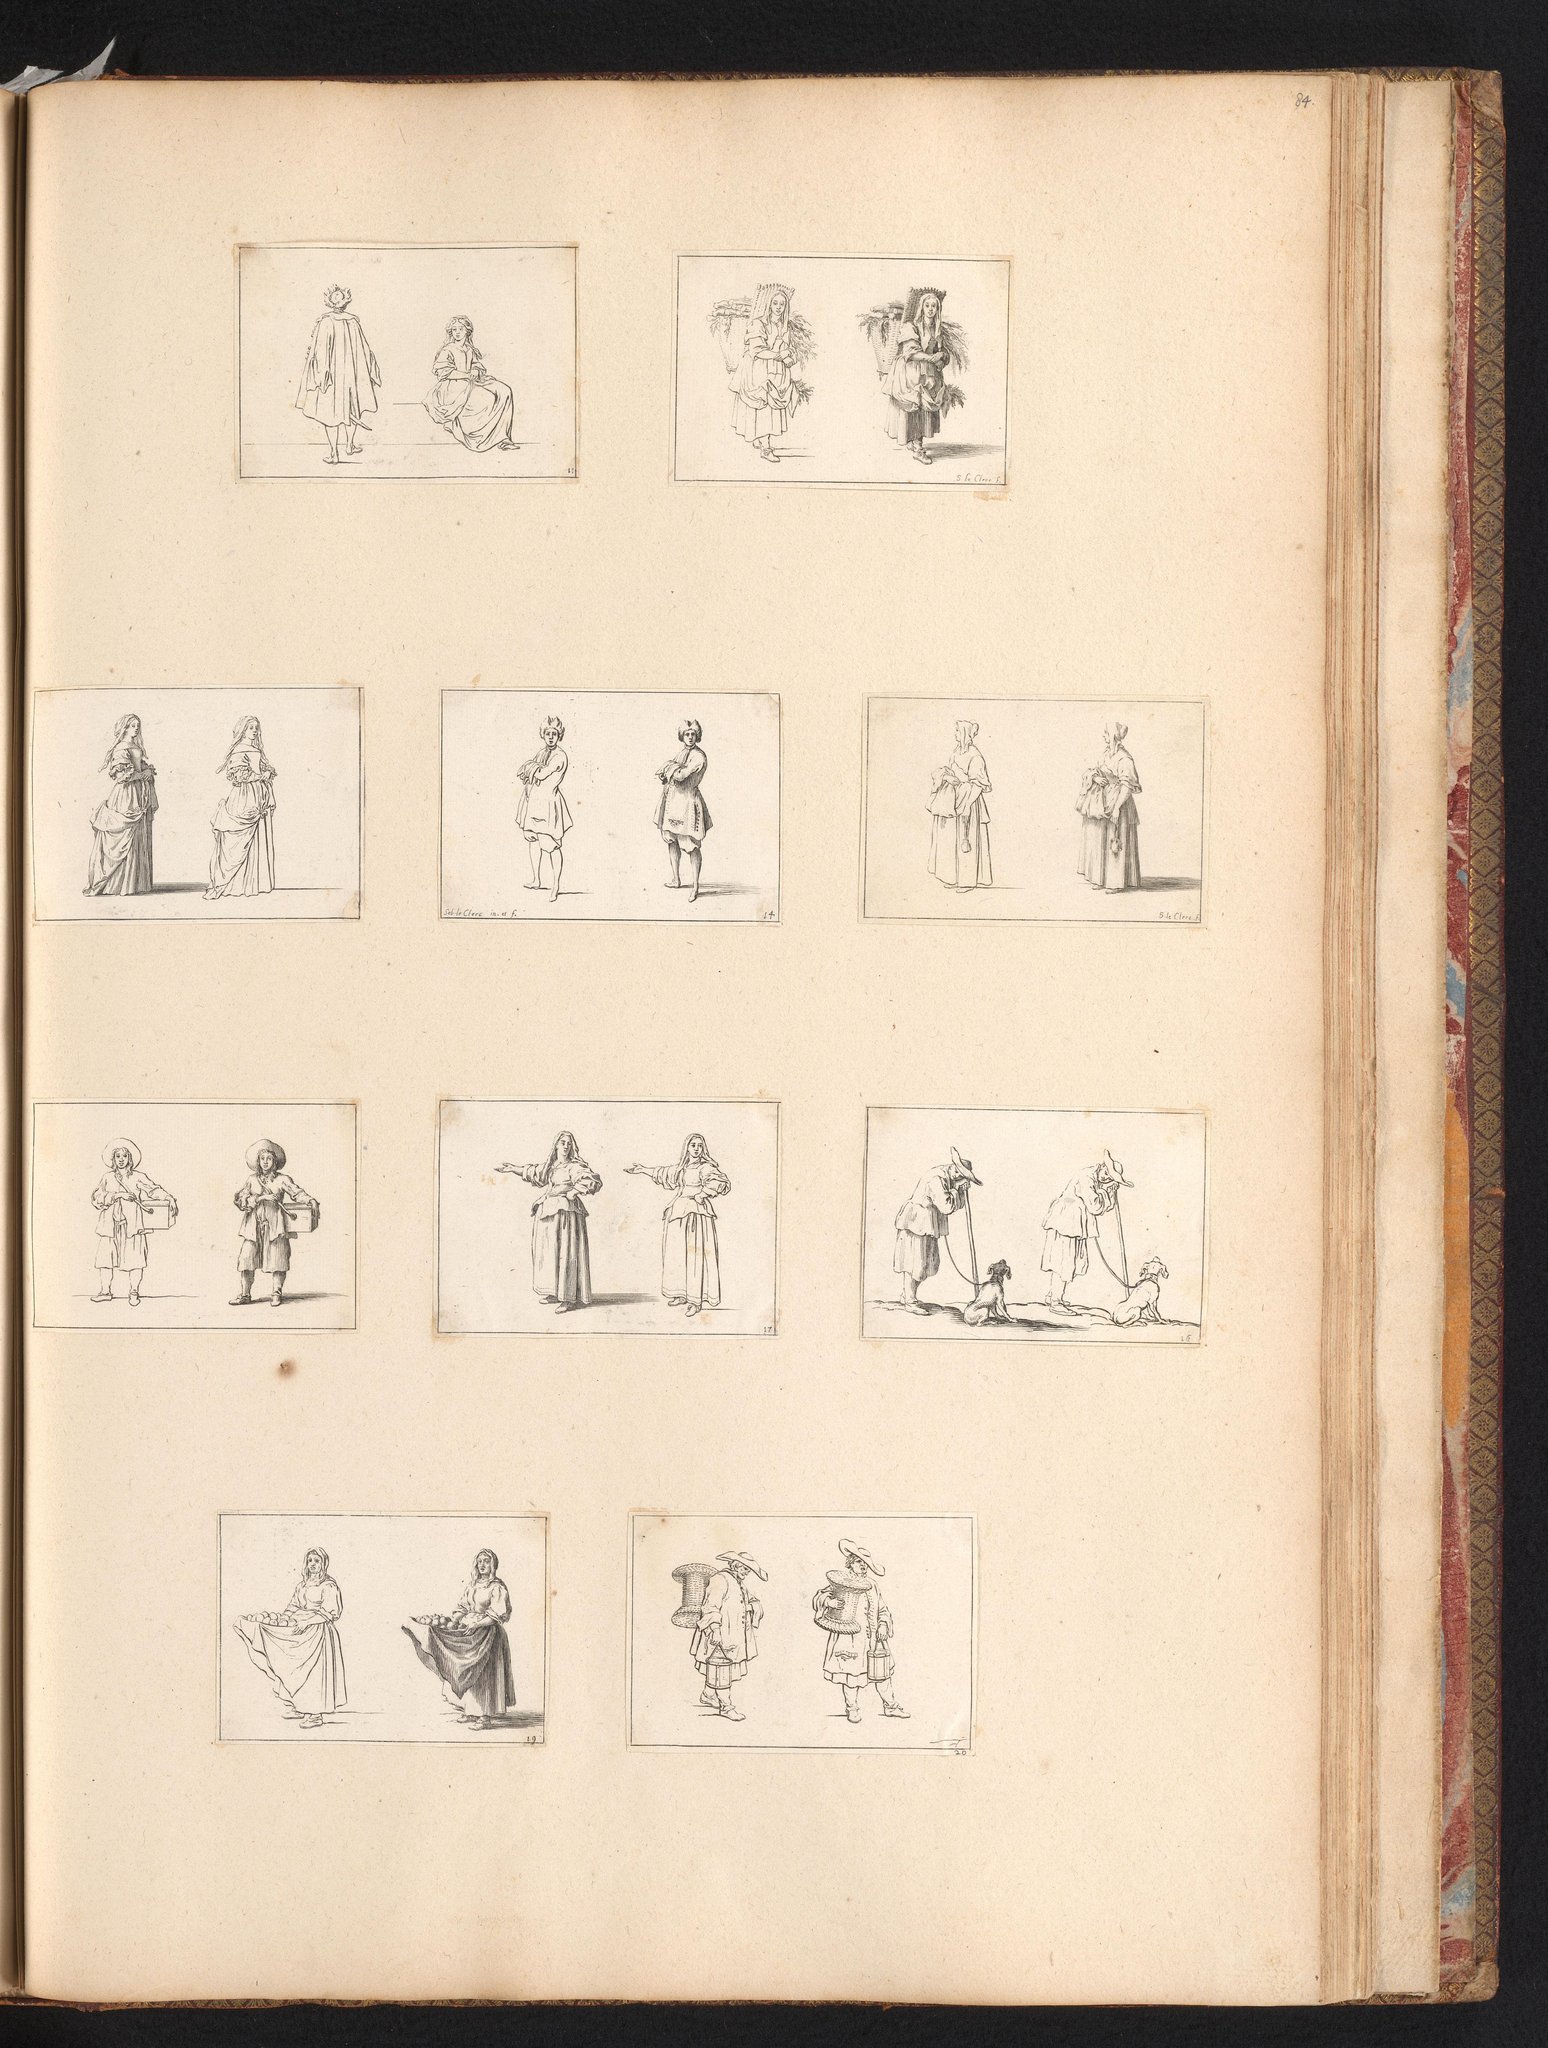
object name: print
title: Figures pour Colbert d'Ormoy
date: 1679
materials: paper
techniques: etching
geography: france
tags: model-books ~ implements of painter, folk costume, regional costume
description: Deze prenten maken deel uit van een dertigdelige serie met tekenvoorbeelden van verschillende alledaagse figuren. Zoals vermeld in IFF 17e siècle leerde Leclerc Colbert volgens Jombert vanaf 1679 tekenen. Hij vervaardigde deze reeks voor Colbert om het leerproces te faciliteren. Op ieder tekenvoorbeeld staan twee figuren, waarvan soms hetzelfde figuur twee keer, soms in een andere pose, soms voorzien van arceringen.